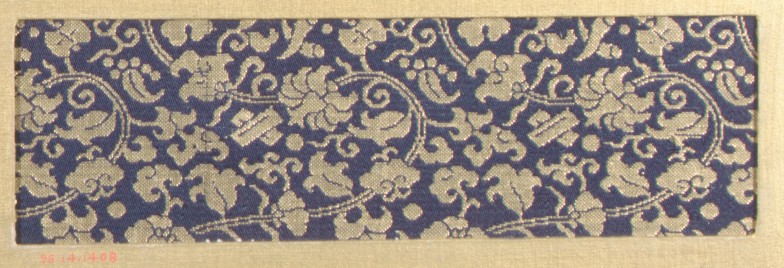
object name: piece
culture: japanese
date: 1701-1900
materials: silk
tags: leaves